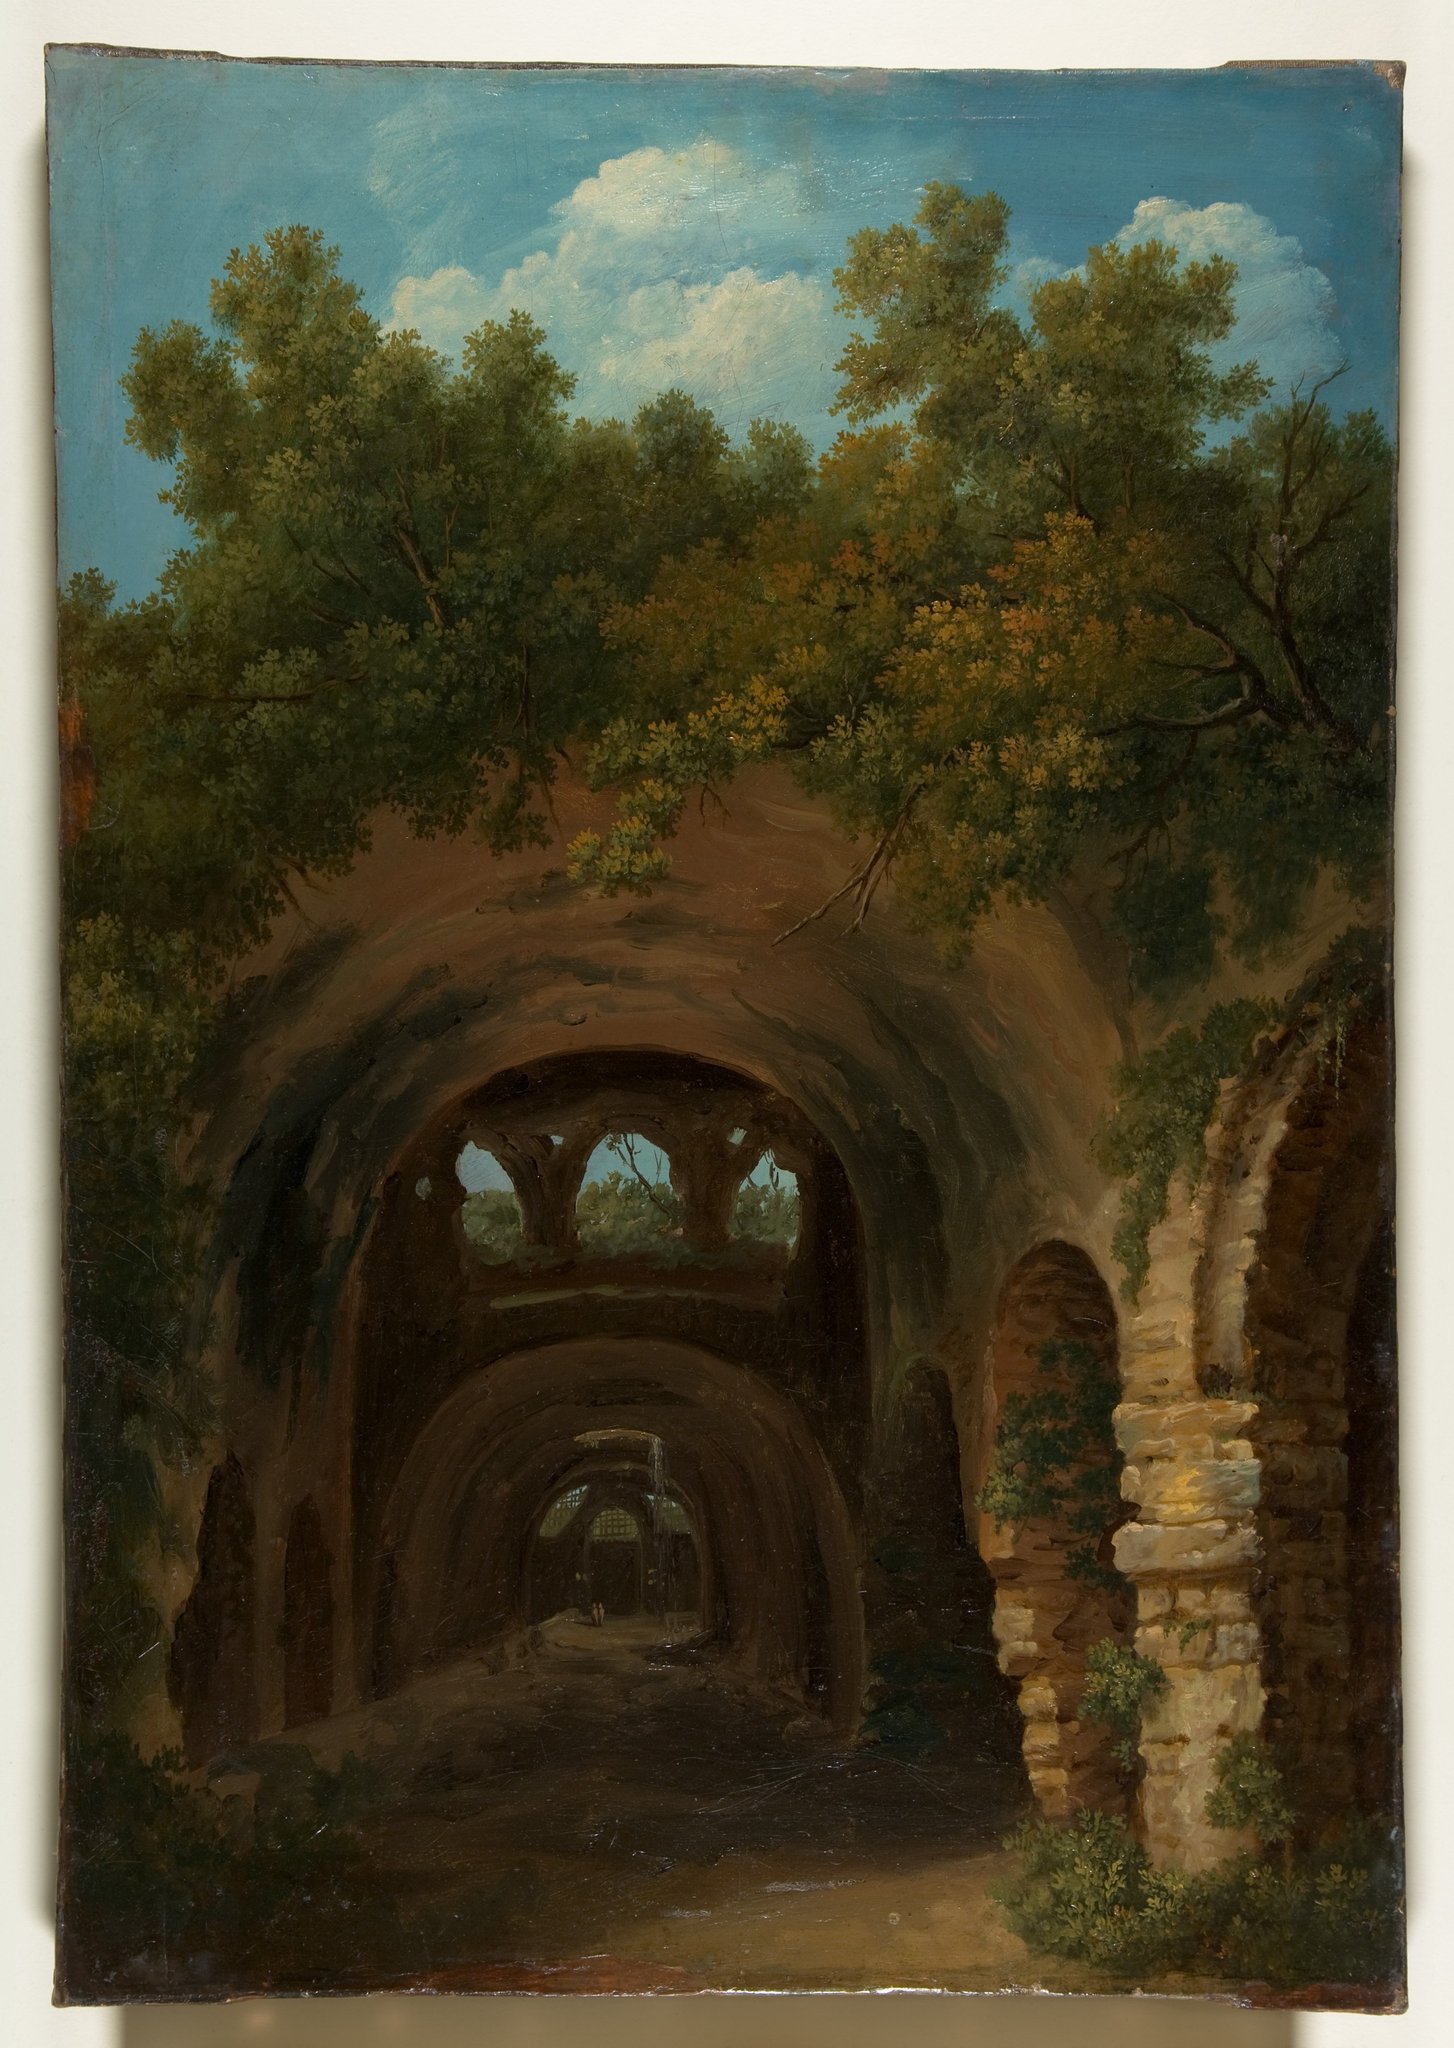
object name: drawing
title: Ruins of a Roman Bath or Reservoir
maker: louis gauffier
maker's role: artist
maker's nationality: french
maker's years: 1762-1801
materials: canvas, oil, paper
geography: france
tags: reservoirs,ruins,trees